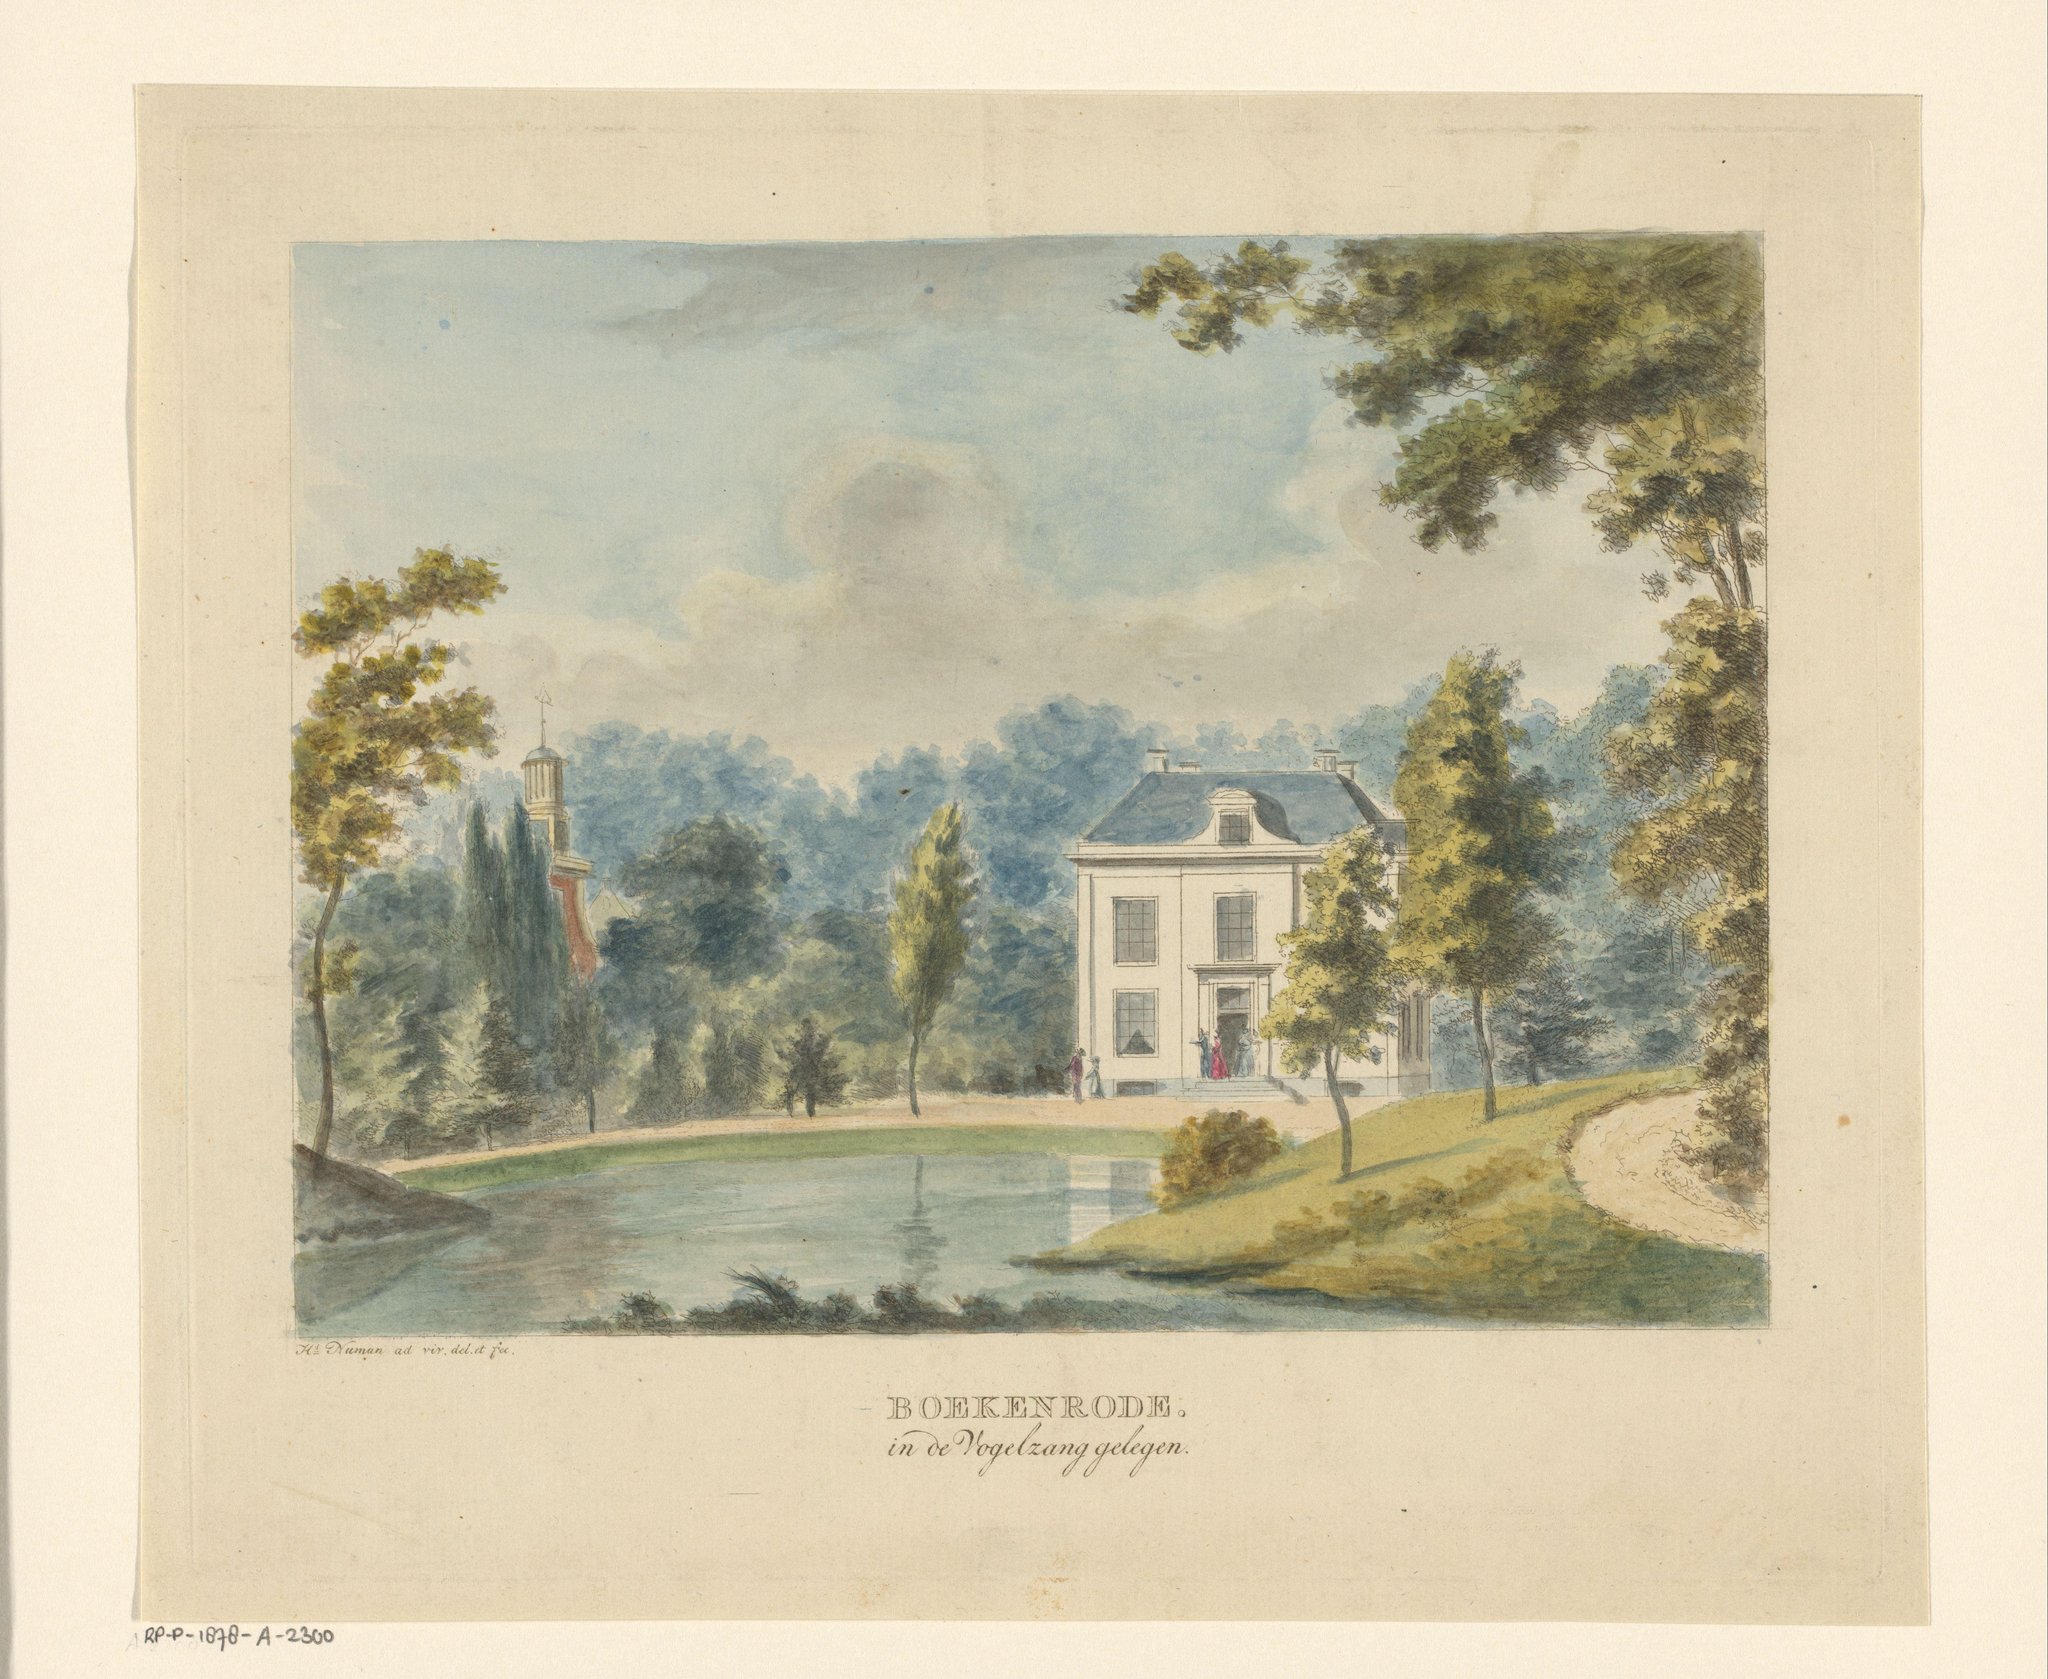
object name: print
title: Buitenplaats Boekenrode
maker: hermanus numan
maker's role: draughtsman, painter, print maker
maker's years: 1744-1820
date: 1790-1797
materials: paper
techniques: etching, hand coloring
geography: netherlands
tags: country-house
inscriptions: collector's mark: Lugt 2228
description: Prent gebruikt in: Numan, Hermanus. Vierentwintig printtekeningen met couleuren, verbeeldende Hollandsche buitenplaatzen. Amsterdam: Jan IJver, Jan Willem Smit en Hermanus Numan, 1797.